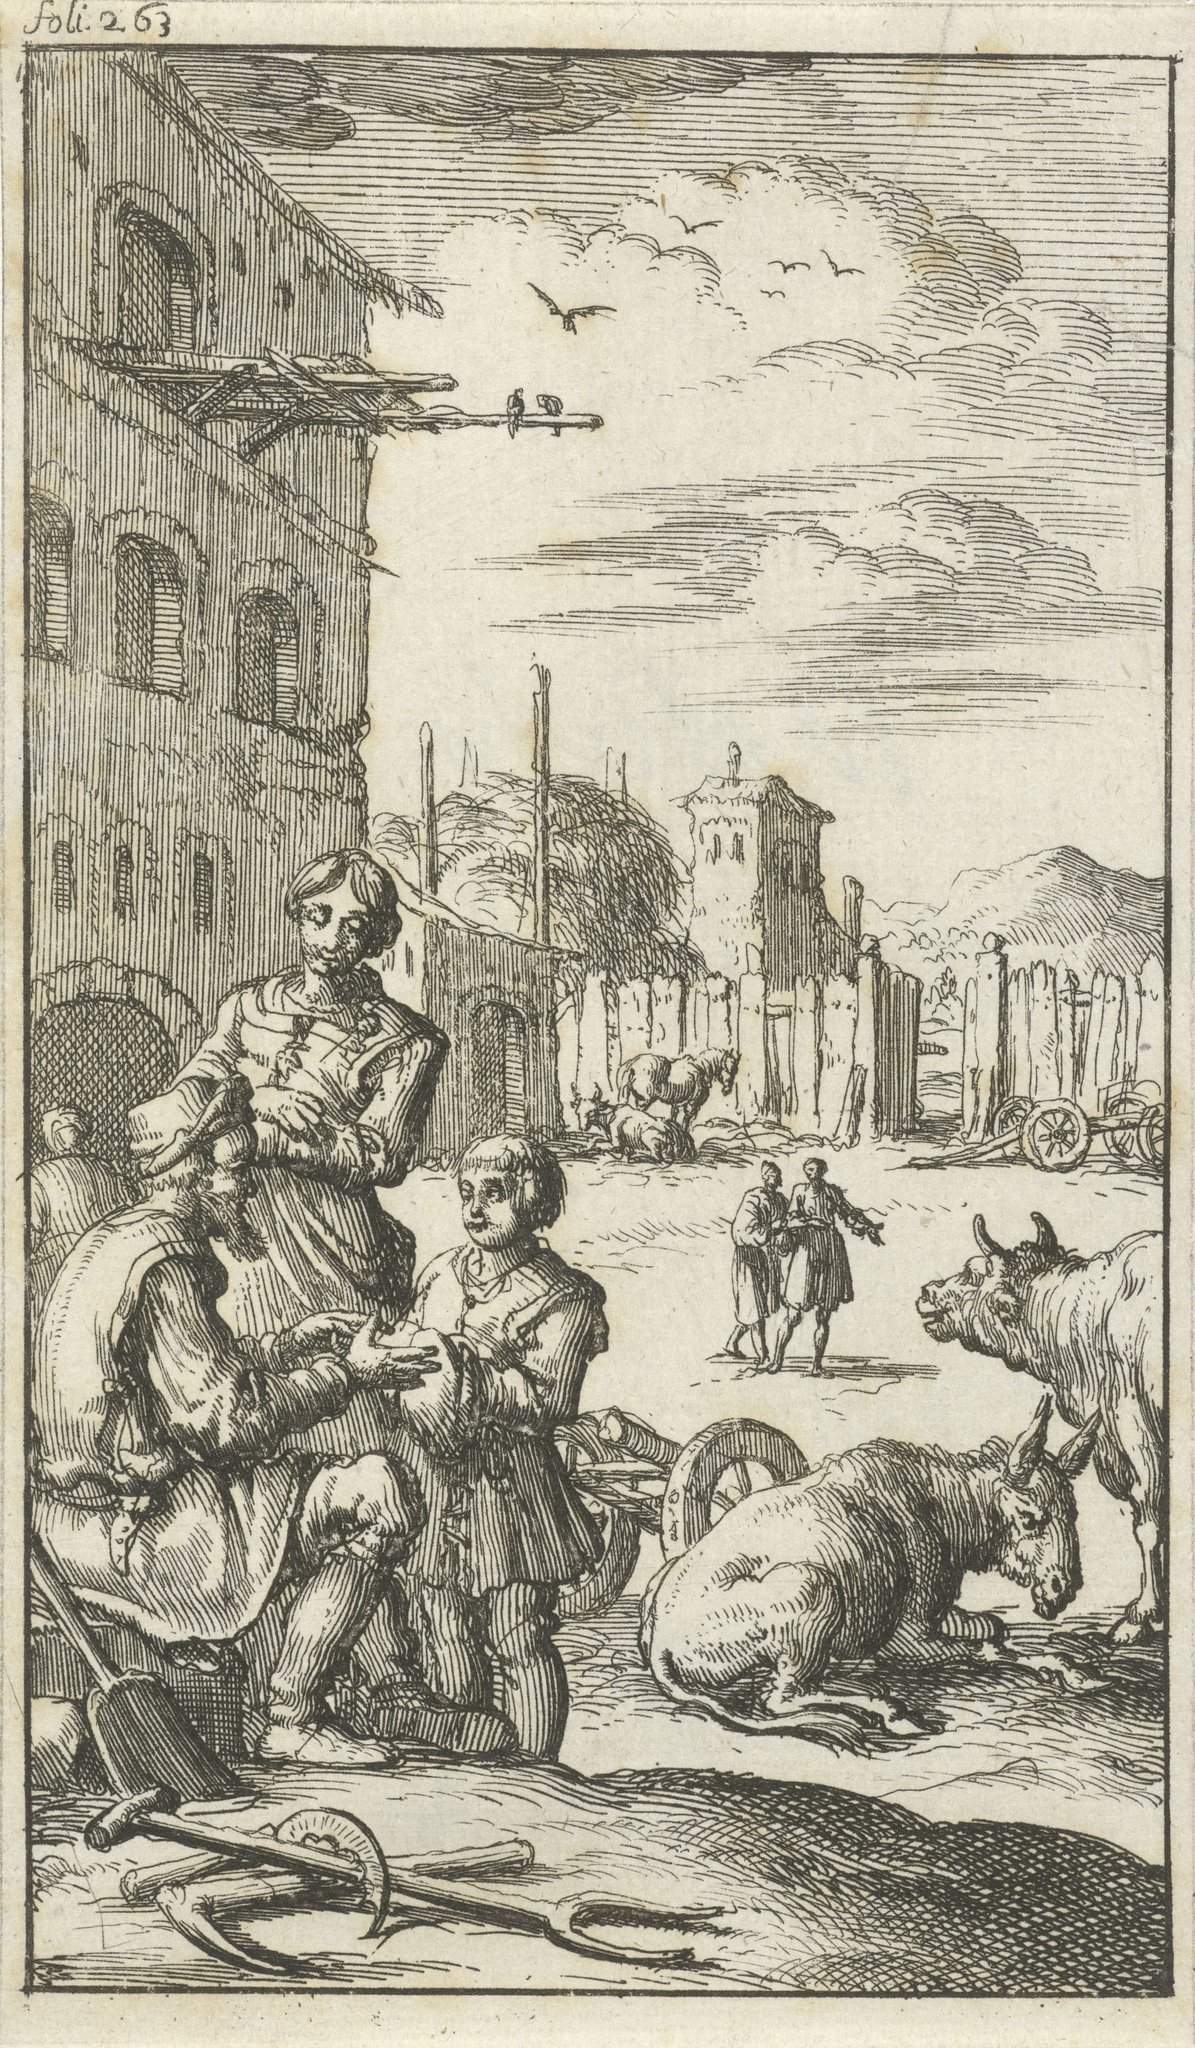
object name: print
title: Gedenk de sabbatdag: het derde Gebod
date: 1685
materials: paper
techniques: etching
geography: amsterdam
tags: old man, mother and baby or young child, conversation, dialogue; conversation piece, village square, place, 'remember the sabbath day' ~ separate representation of the fourth of the ten commandments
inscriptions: collector's mark: Lugt 2228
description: Illustratie uit: Hondorffius, Andreas. De tien geboden des Heeren. Amsterdam: Jan Bouman, 1685.